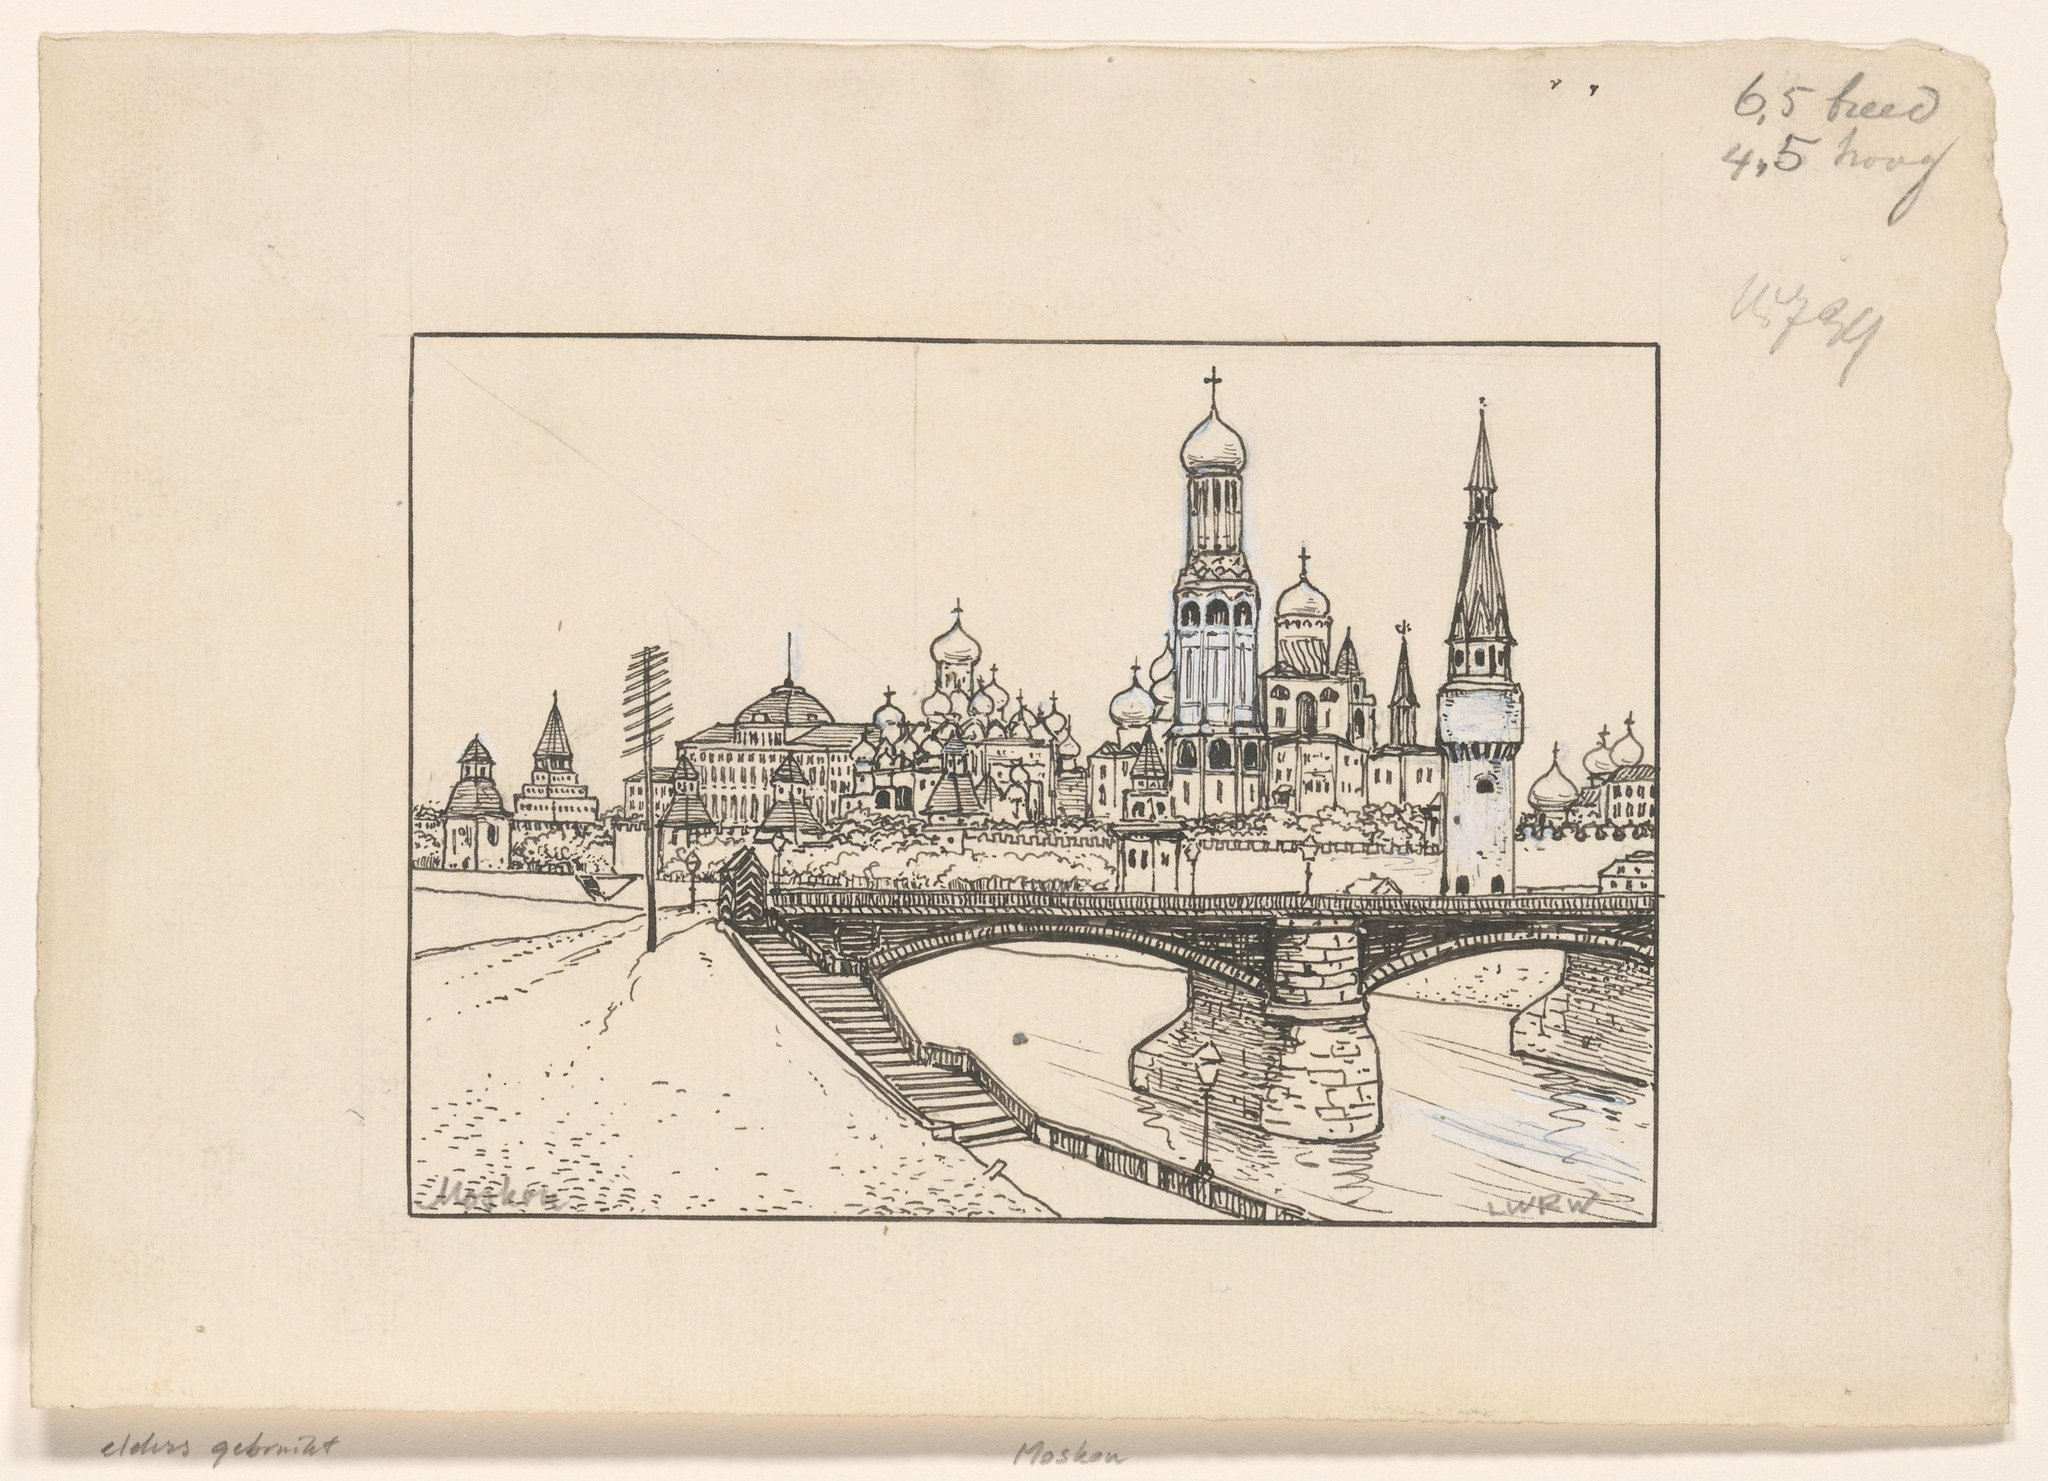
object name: drawing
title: Gezicht op het Kremlin te Moskou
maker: willem wenckebach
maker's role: designer, draughtsman, painter, print maker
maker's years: 1860-1937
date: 1870-1937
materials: paint, ink, paper, pencil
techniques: brush, pen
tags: city-view, and landscape with man-made constructions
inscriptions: clichéaanwijzing, recto, handgeschreven